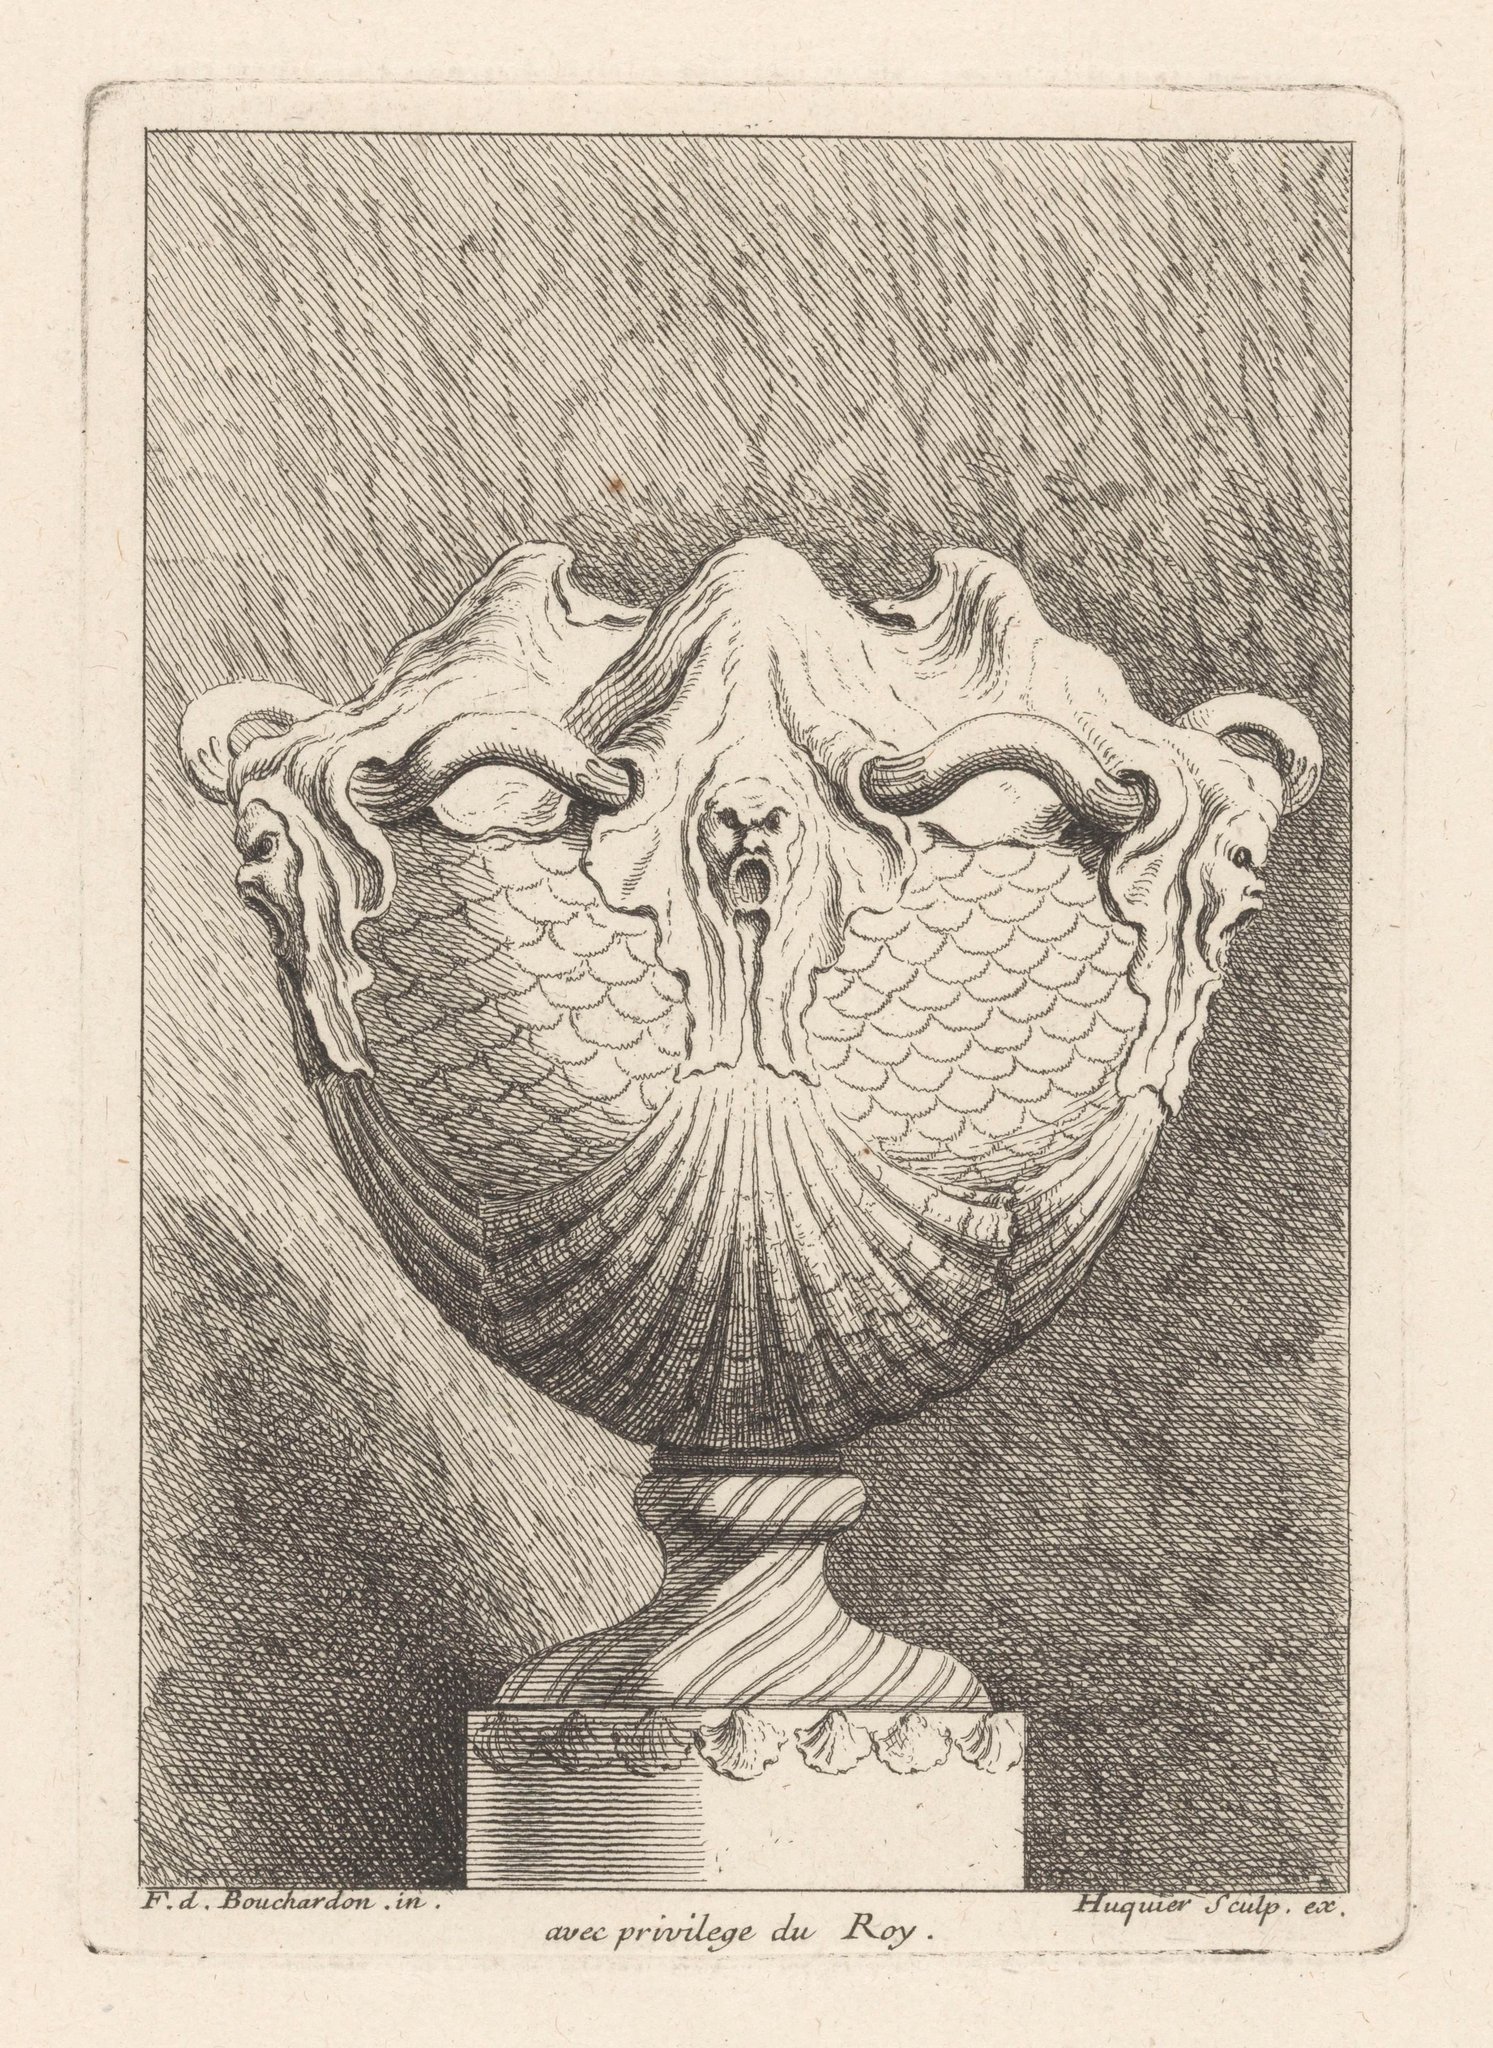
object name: print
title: Second livre de vases (...)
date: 1729-1737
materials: paper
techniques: etching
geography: paris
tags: vase ~ ornament, scallop, shell ~ ornament, mask, mascaron ~ ornament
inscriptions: collector's mark: Lugt 2228